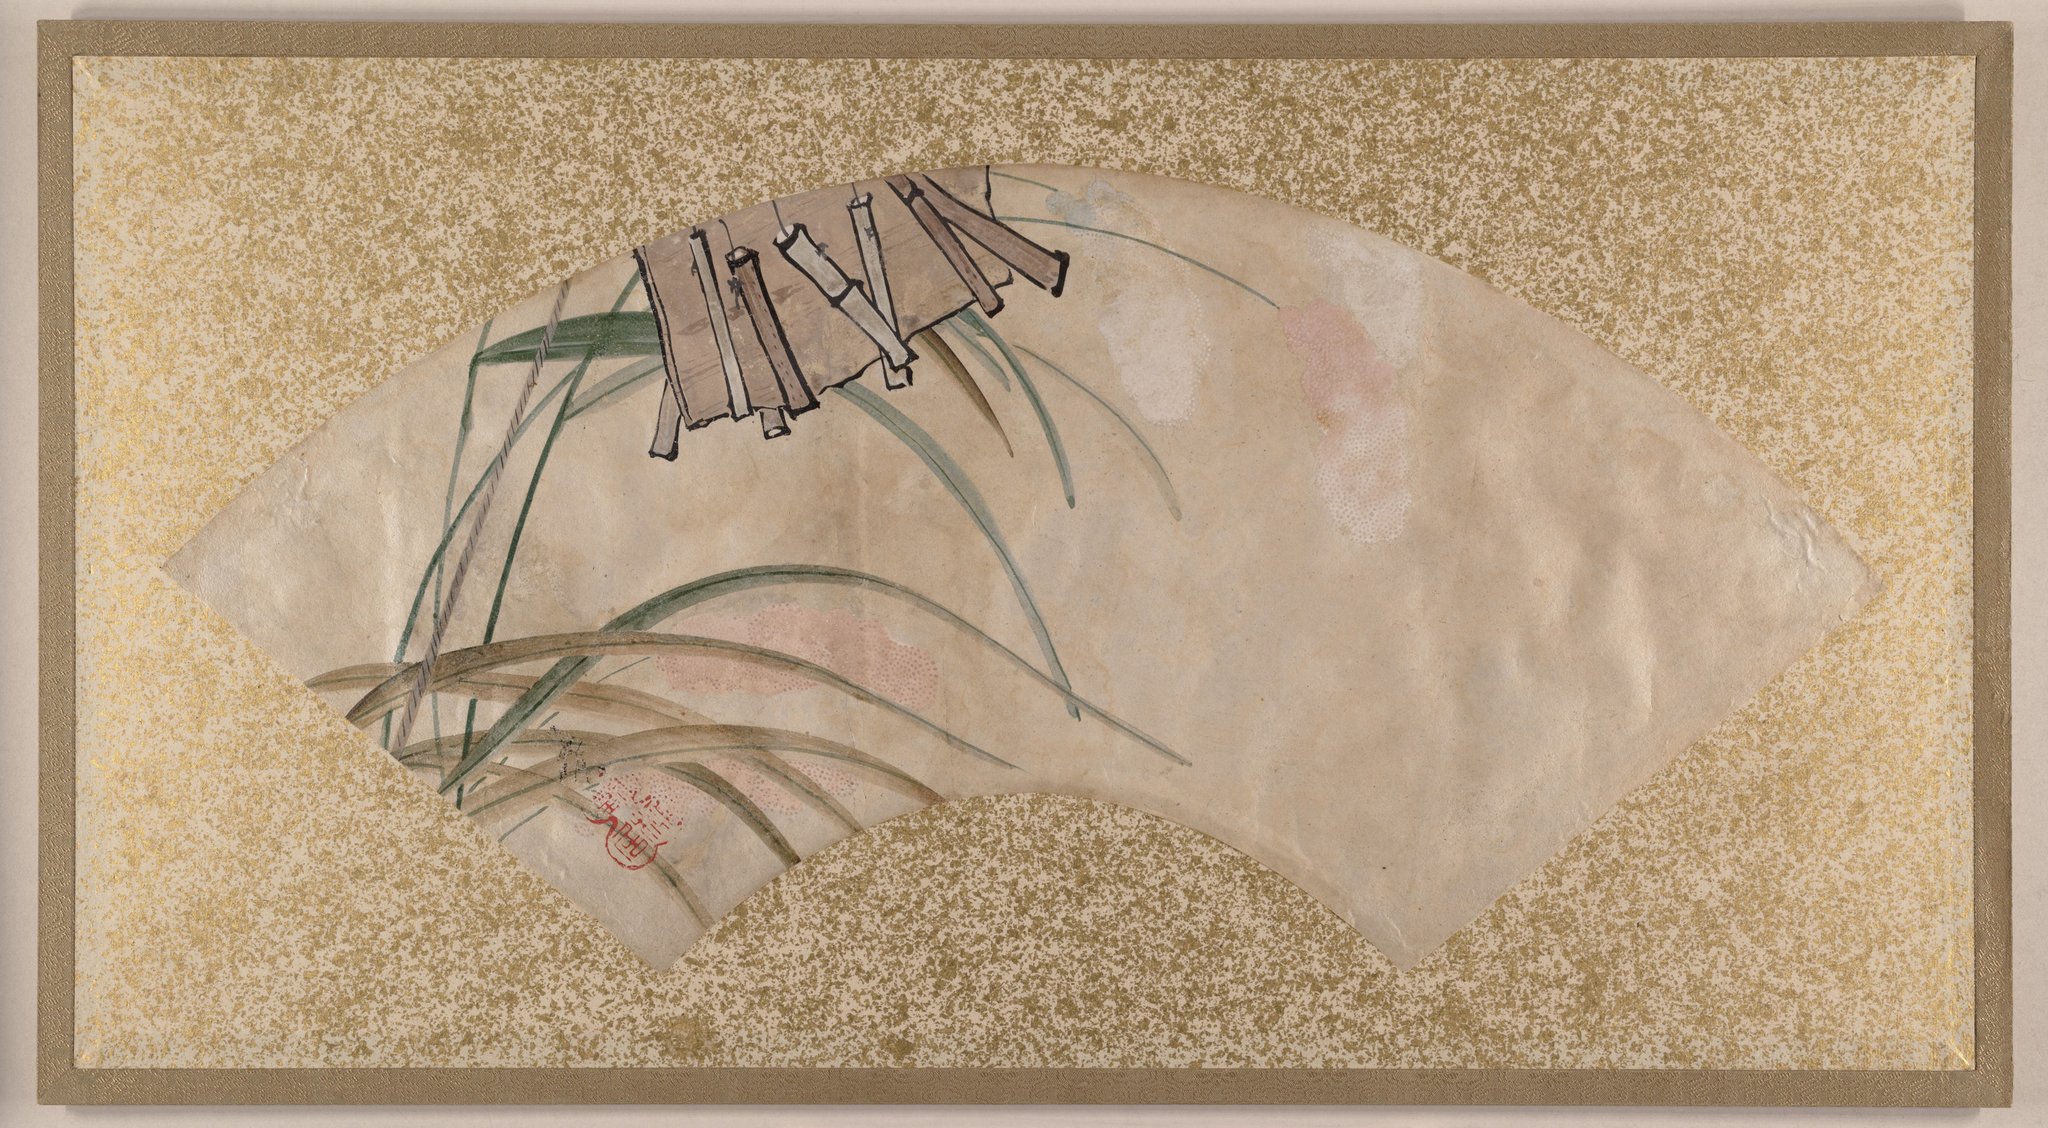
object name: album leaf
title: Flowers (pink and white) and Leaves, Clappers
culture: japanese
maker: shibata zeshin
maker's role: artist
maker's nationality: japanese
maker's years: 1807-1891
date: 1867-1900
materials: paper, paint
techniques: painting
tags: musical instruments,flowers